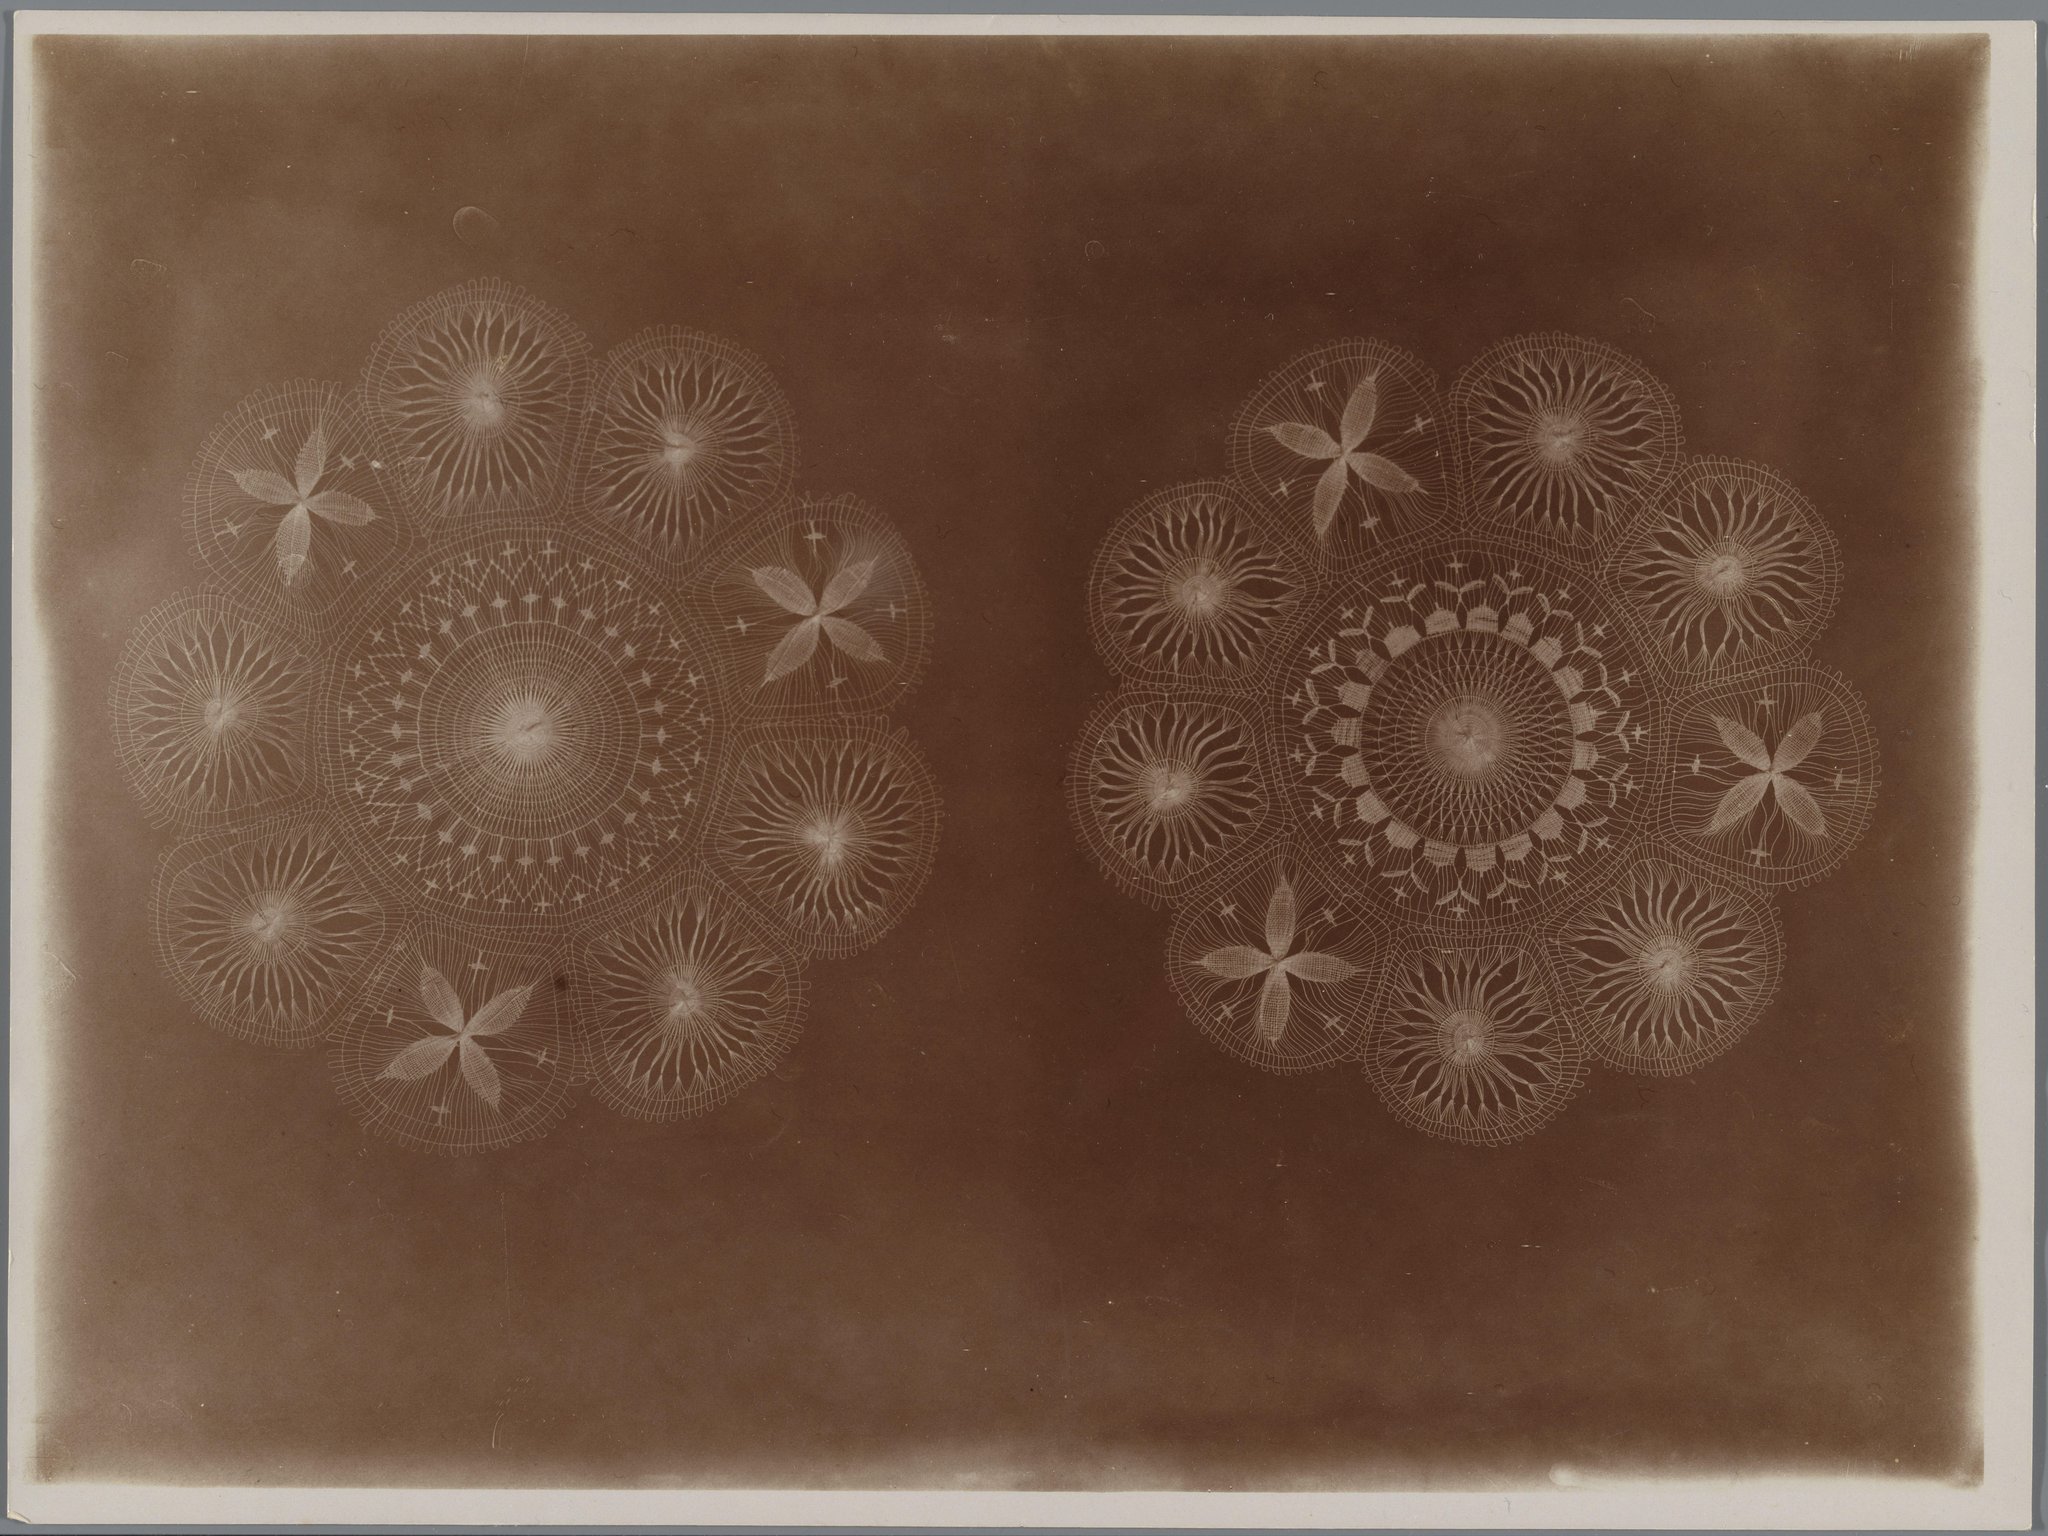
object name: photograph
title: Twee kleden van kant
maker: Anonymous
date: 1890-1920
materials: paper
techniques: gelatin silver print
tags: lace